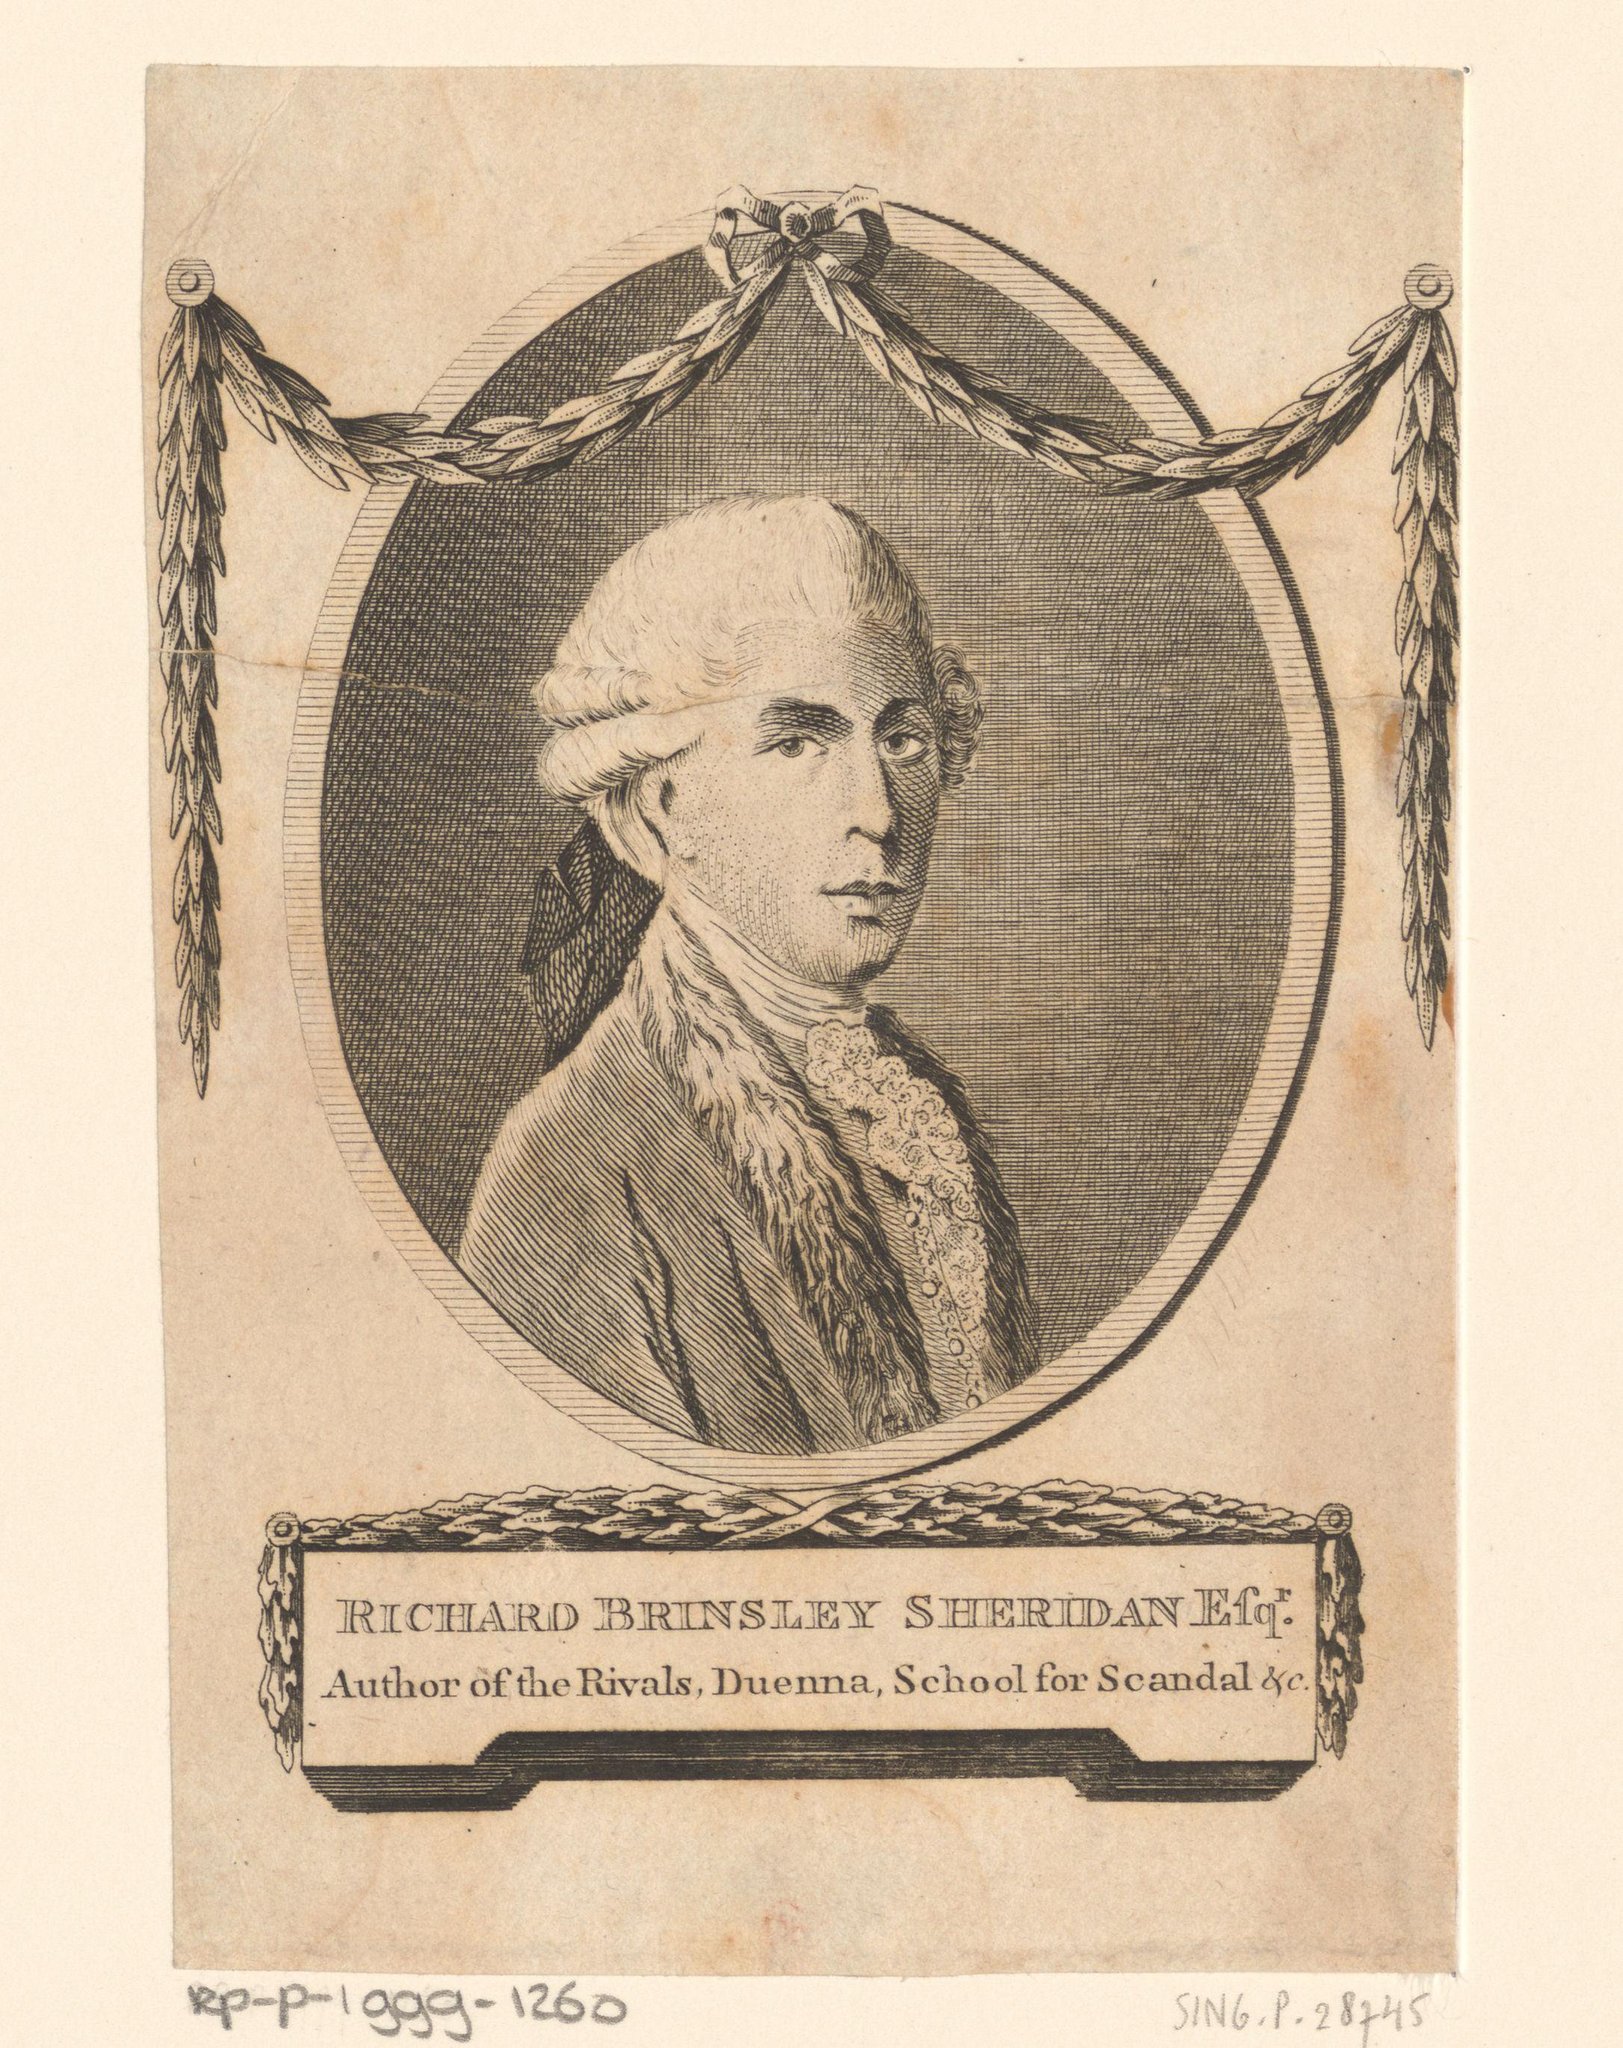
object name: print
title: Portret van Richard Brinsley Sheridan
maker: Anonymous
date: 1777-1850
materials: paper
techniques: engraving, etching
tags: official; civil servant; functionary (in general), historical persons, portrait of a writer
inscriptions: collector's mark: Lugt 2760, collector's mark: Lugt 2228